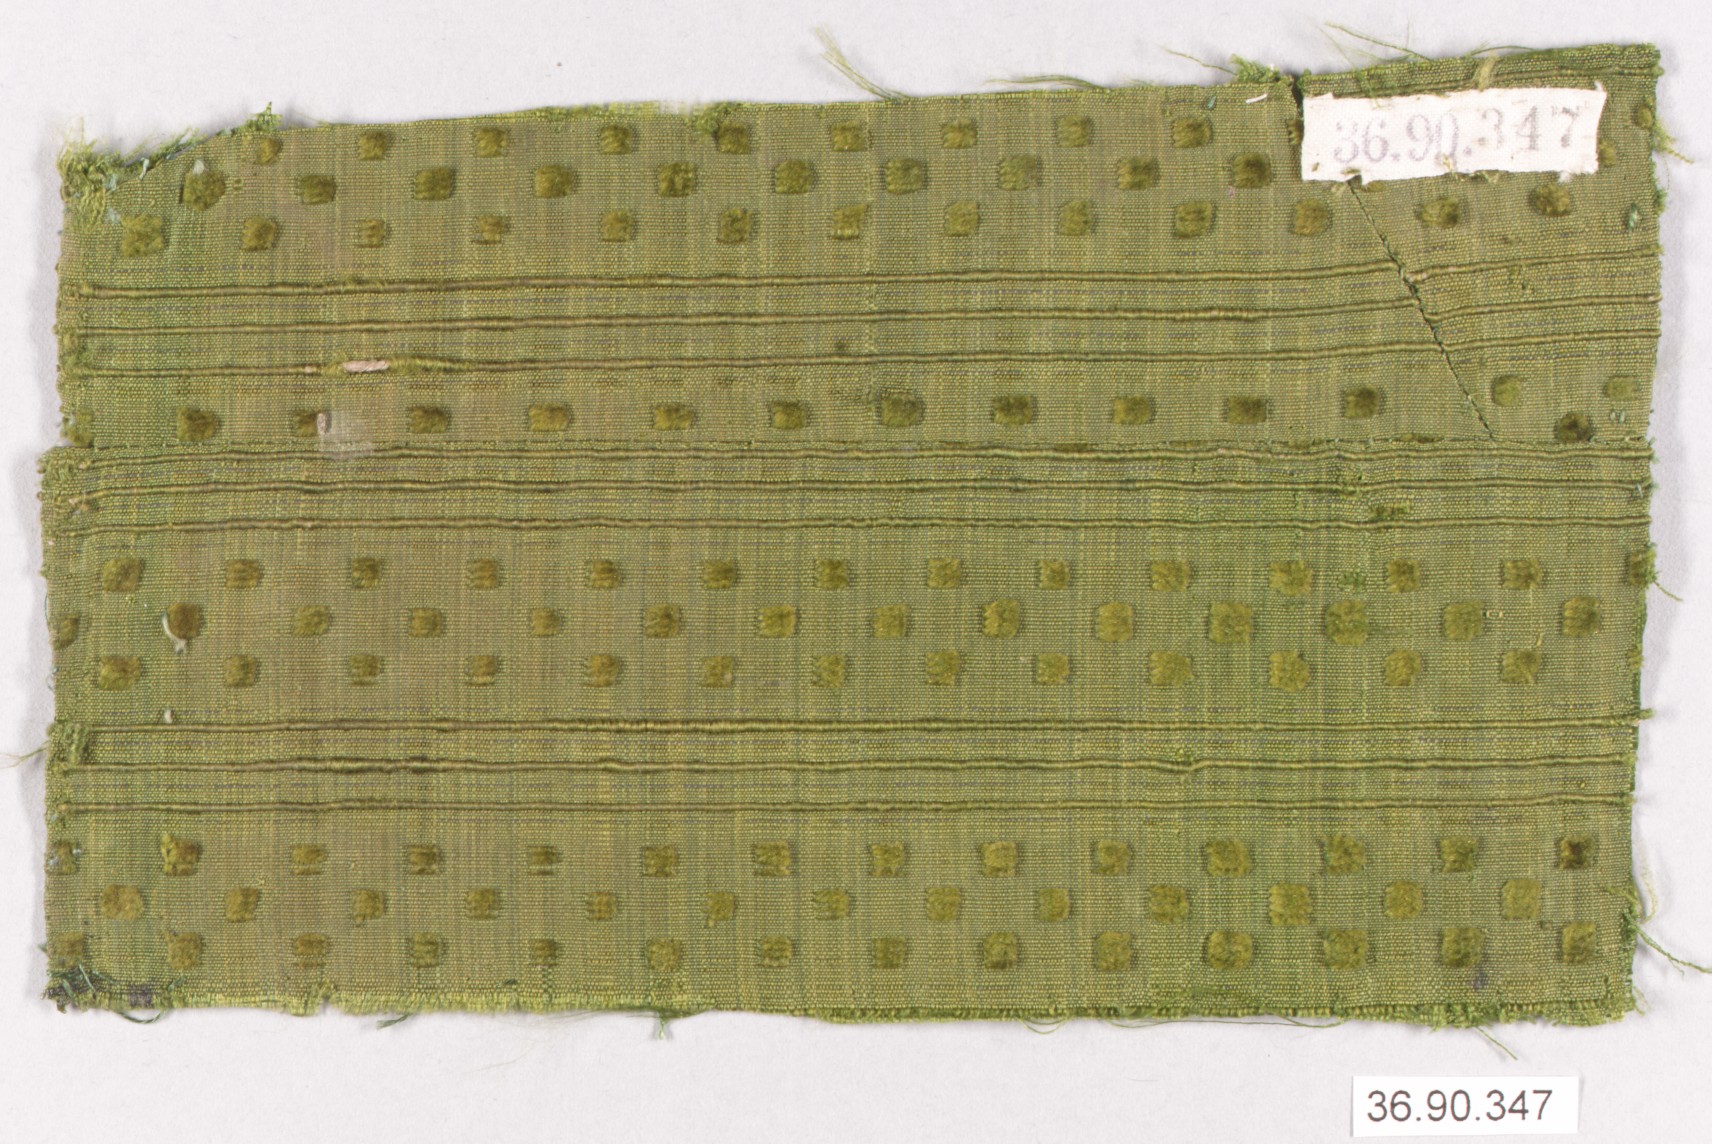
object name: piece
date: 1501-1700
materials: metal thread, silk